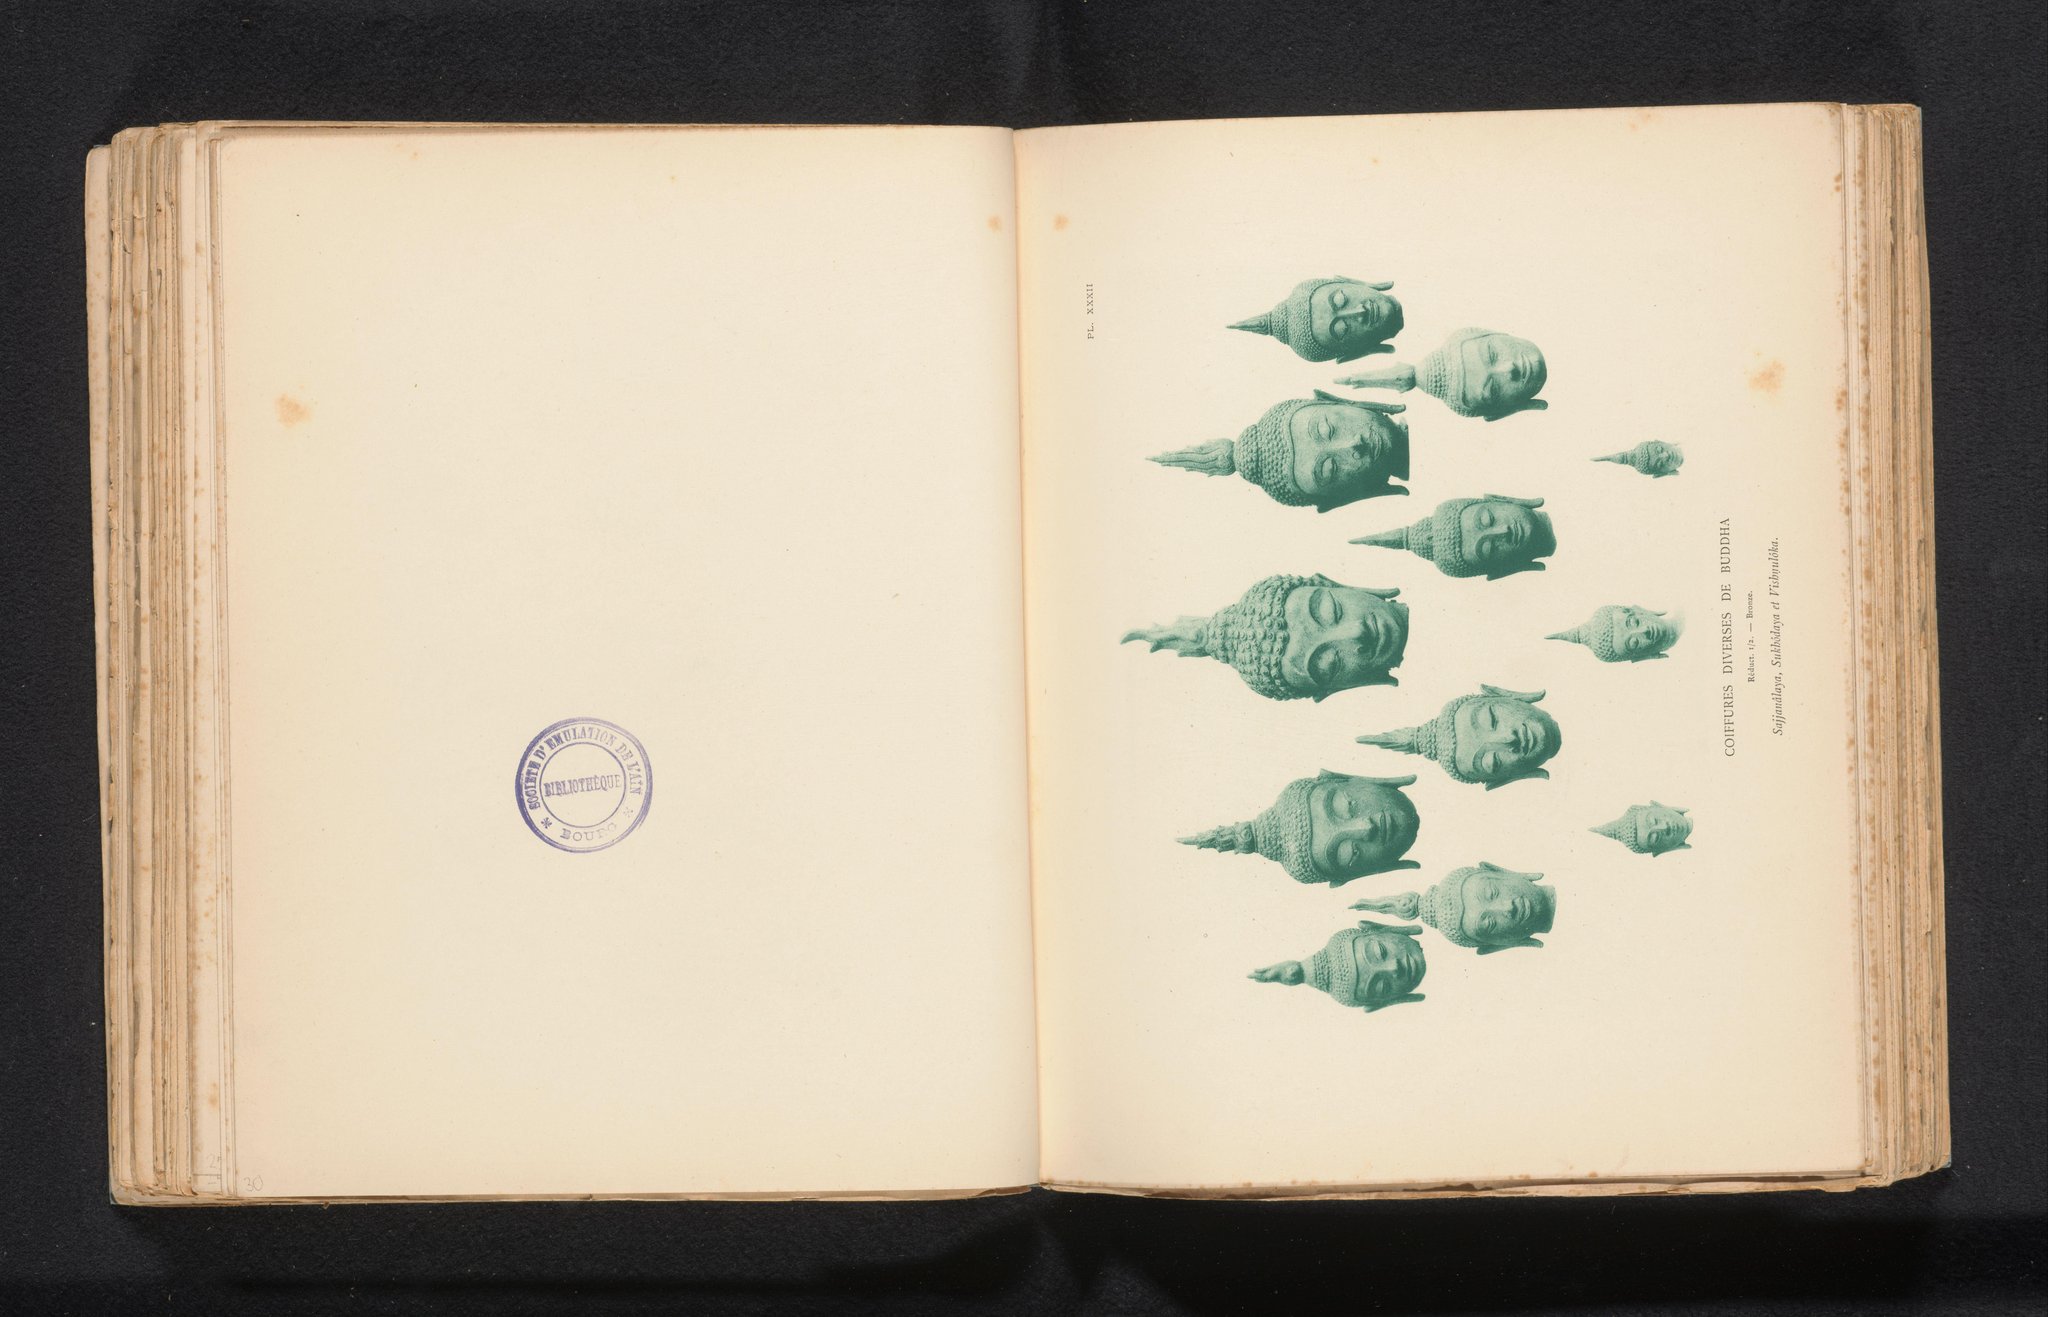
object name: page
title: Twaalf hoofden van sculpturen van Boeddha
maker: Anonymous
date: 1890-1895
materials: paper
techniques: photograph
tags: representations ~ gods, demi-gods, heroes, etc. (hinduism, buddhism, jainism)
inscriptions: collector's mark: ‘Société d'Emulation de l'Ain/ Bourg/ Bibliothèque’, inscription: ‘Réduct 1/2. - Bronze/ Sajjanâlaya, Sukhôdaya et Vishnulóka’, inscription: ‘Pl. XXXII’